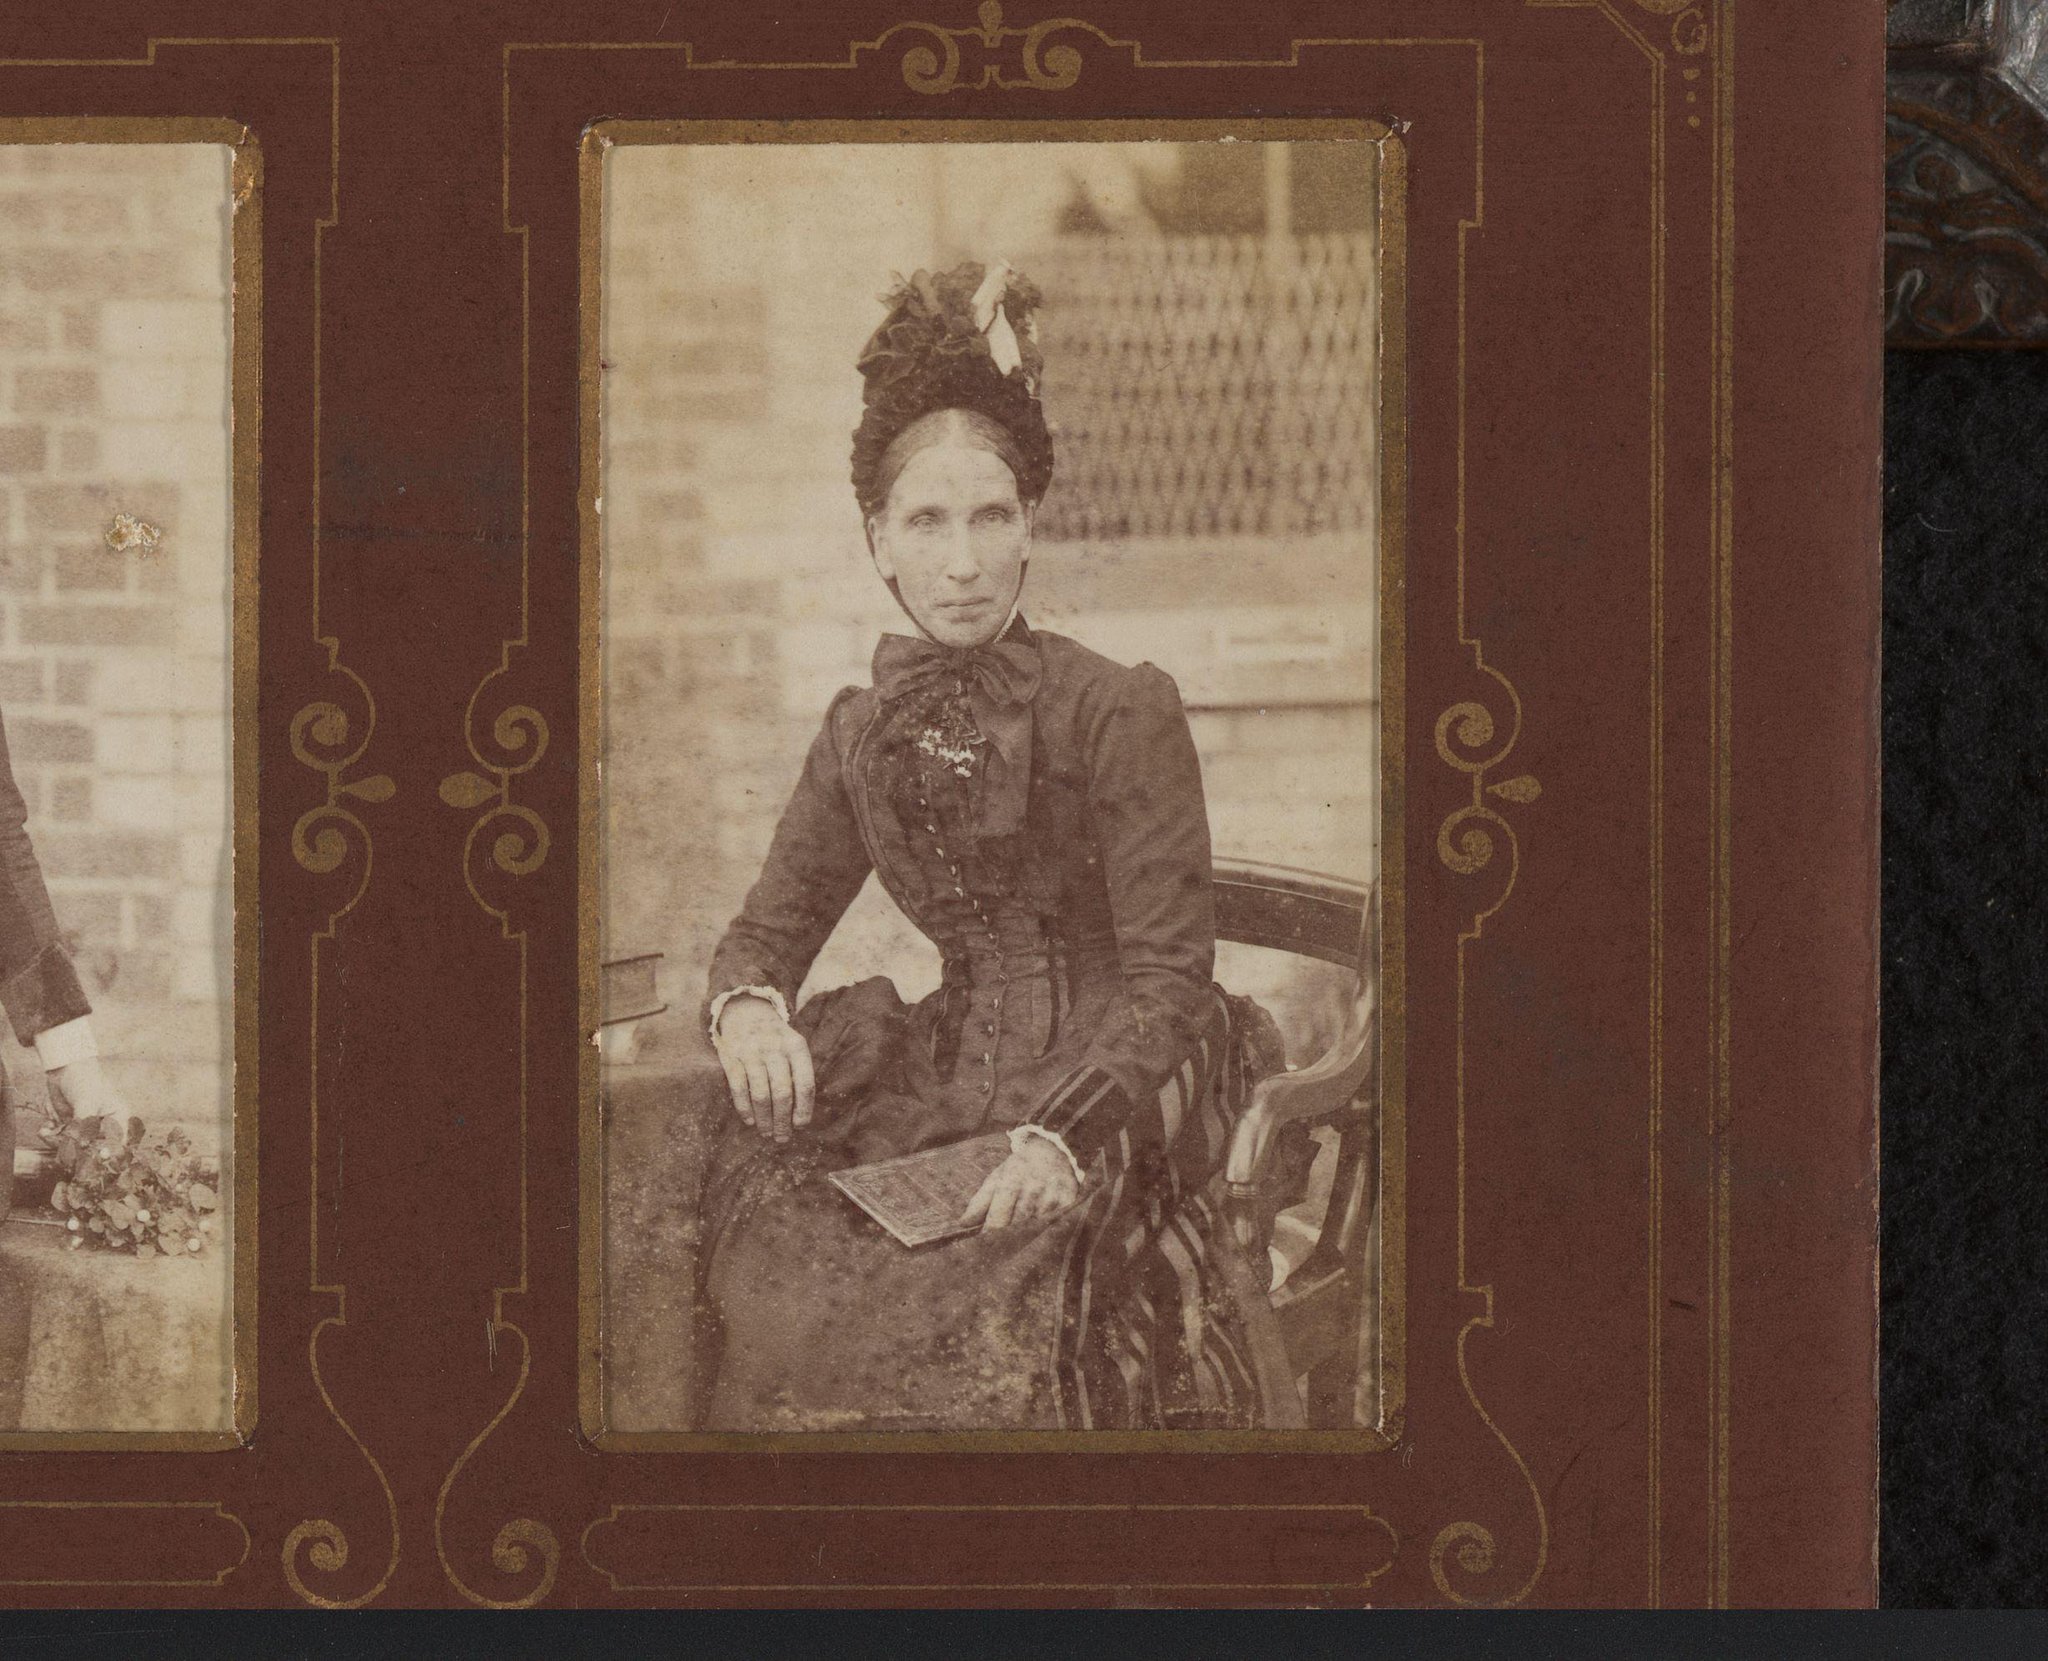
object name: carte de visite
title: Portret van een zittende vrouw met muts en boek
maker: w.g. roberts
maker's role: fotograaf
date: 1860-1900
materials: cardboard, photographic support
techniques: albumen print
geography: london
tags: sitting figure - aa - female human figure, historical persons - bb - woman, head-gear: hat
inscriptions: inscription: ‘From the art studio of/ W.G> Roberts/ 96 Prince of Wales Road/ Kentish Town/ London, N.W.’